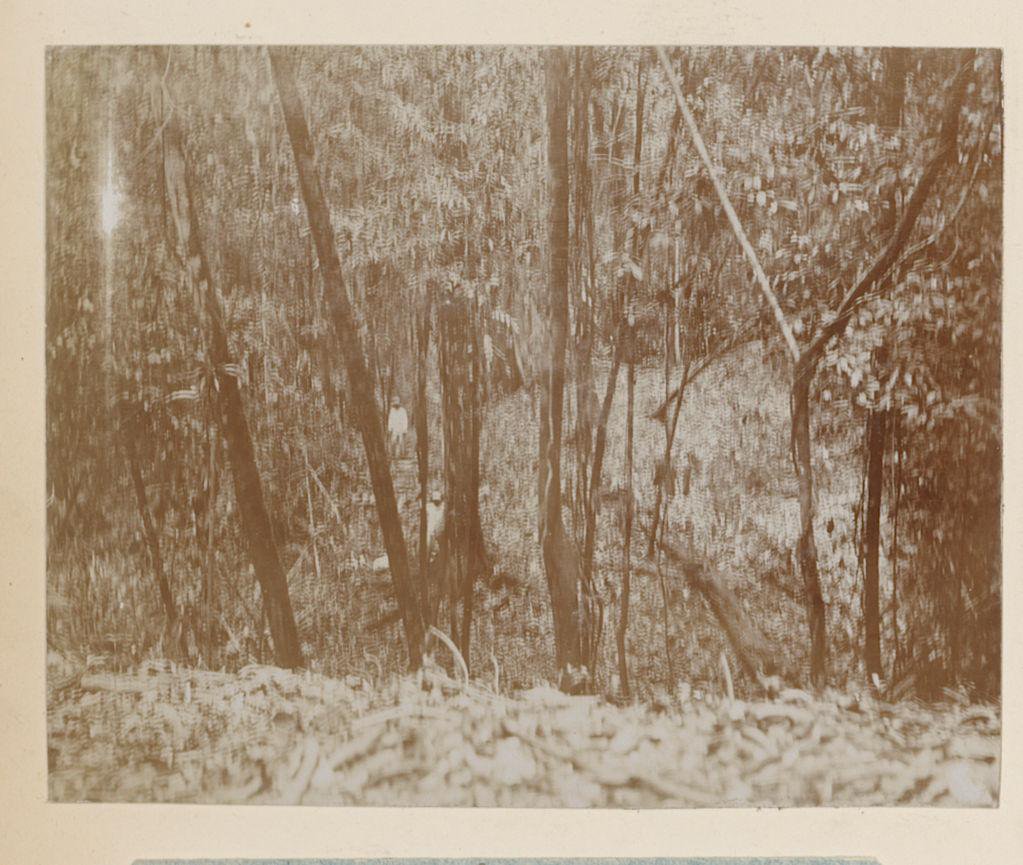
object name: photograph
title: Octobre 1910. Pernantian "le long du trace du chemin"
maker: Anonymous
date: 1910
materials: photographic support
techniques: collodion silver print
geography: east sumatra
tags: plantation, (non-fruit) products of plants or trees: rubber, woodcutting, woodcutter ~ forestry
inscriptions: inscription: ‘Octobre 1910. Pernantian "le long du trace du chemin"’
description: Beboste terrein voor de weg naar Pernatian in 1910. Onderdeel van het fotoalbum over de plantages Brussel en Pernantian van de Sumatra Caoutchouc Maatschappij op de Oostkust van Sumatra in de jaren 1910-1935.